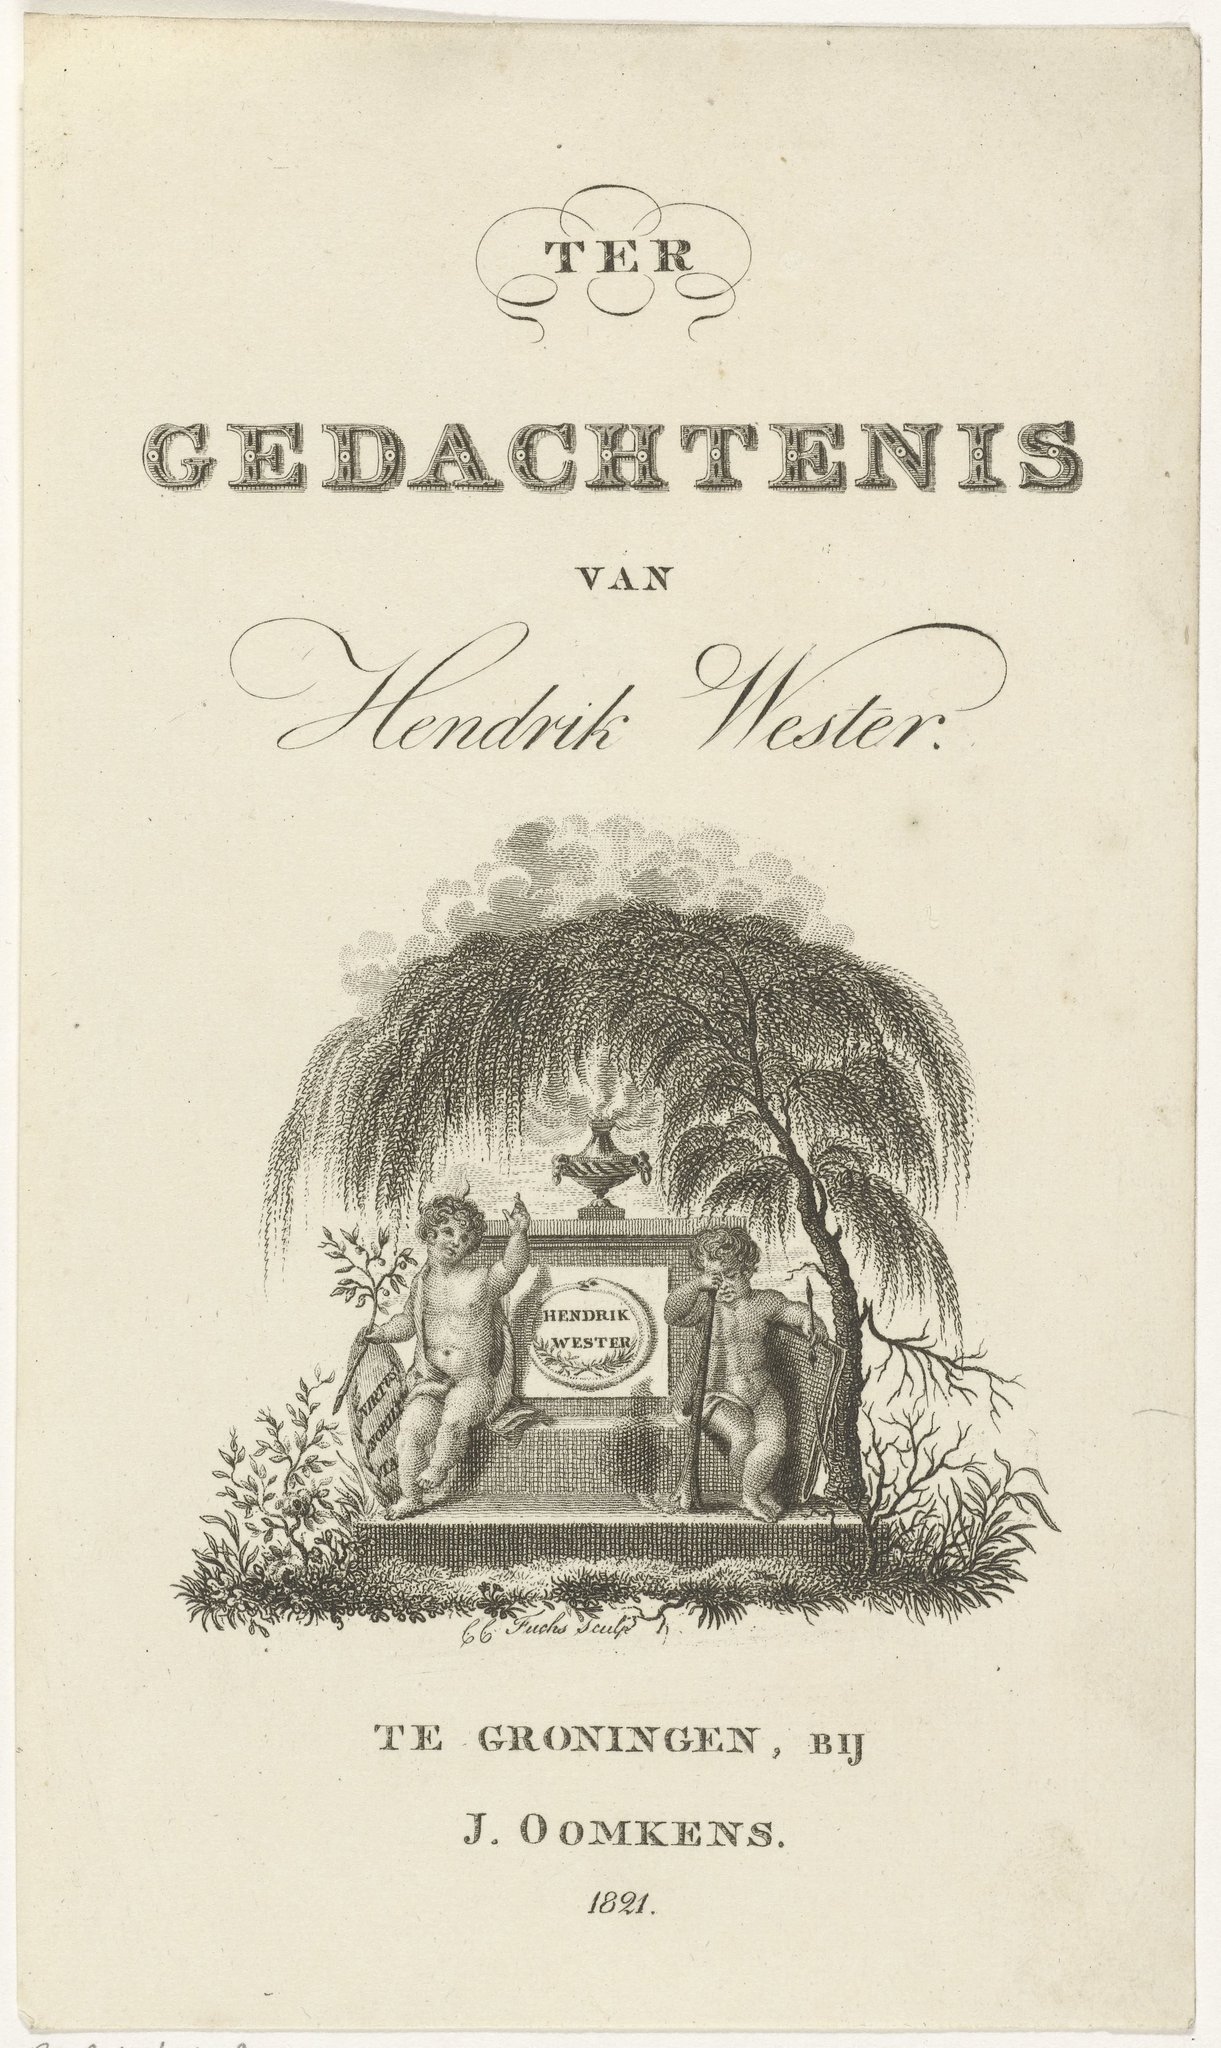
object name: print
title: Twee putti bij een graf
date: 1821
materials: paper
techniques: etching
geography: amsterdam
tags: grave, tomb, serpent ouroboros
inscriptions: collector's mark: Lugt 2228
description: Titelpagina voor de uitgave van een boek ter gedachtenis van Hendrik Wester. Onder de titel een afbeelding van het graf waarop twee rouwende putti zitten met lauriertak en rechte trompet, symbolen die blijk geven van zijn faam als literator. Op het graf is de naam Hendrik Wester omringd door een slang met de staart in de bek, symbool van eeuwigheid. Bovenop het graf een rokende asurn.